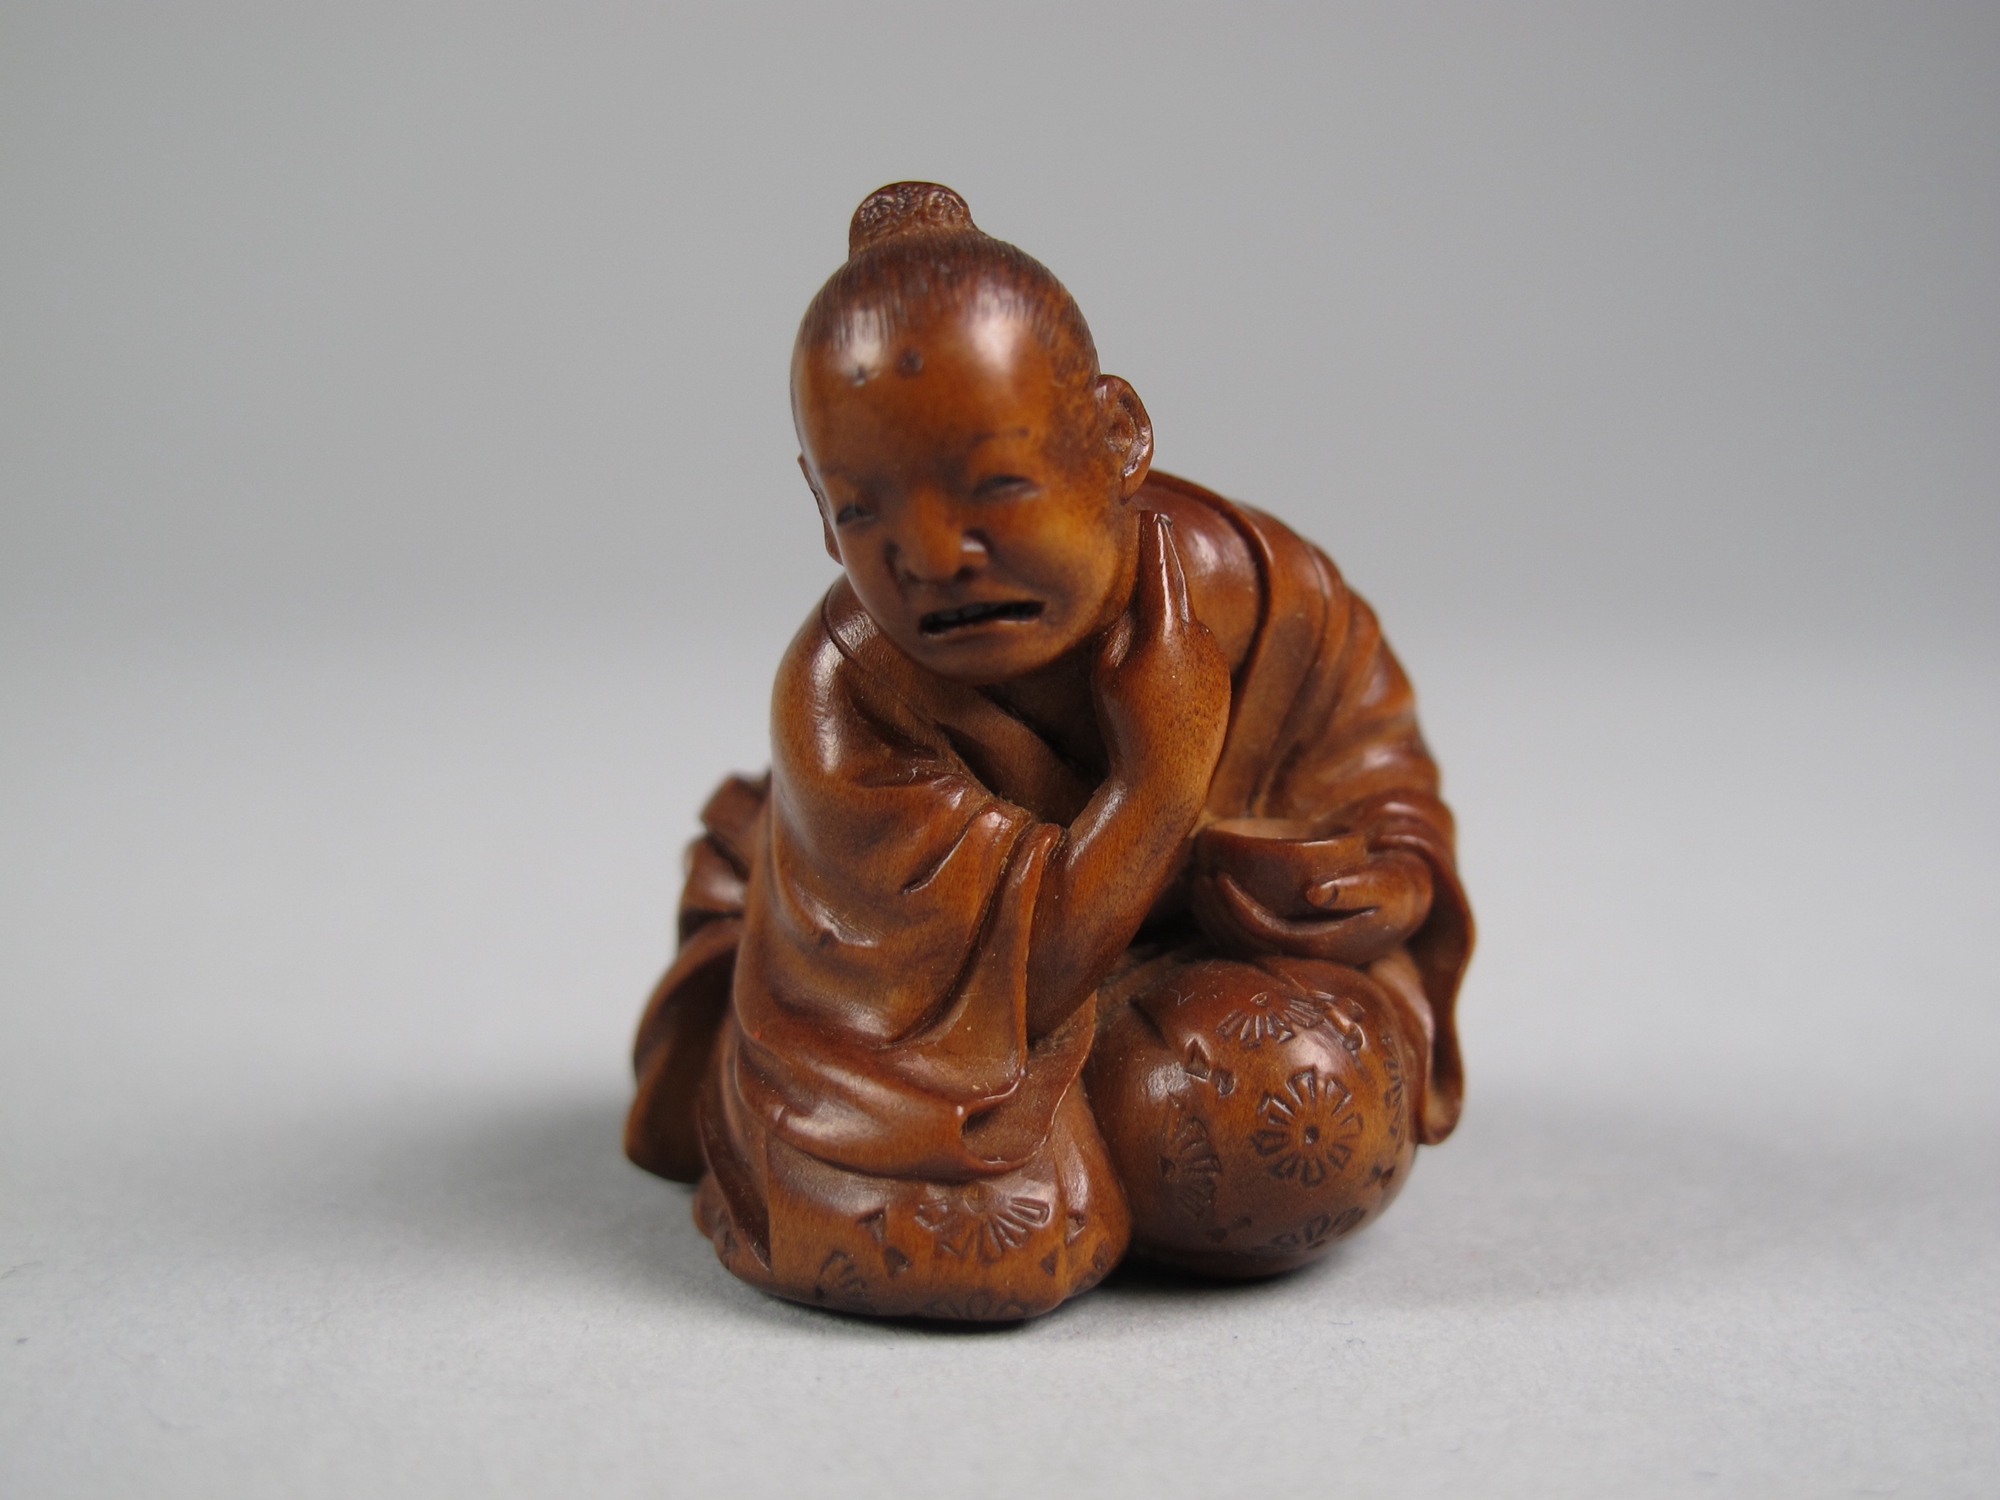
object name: netsuke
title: Netsuke of Man Applying Salve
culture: japanese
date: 1801-1900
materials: wood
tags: men